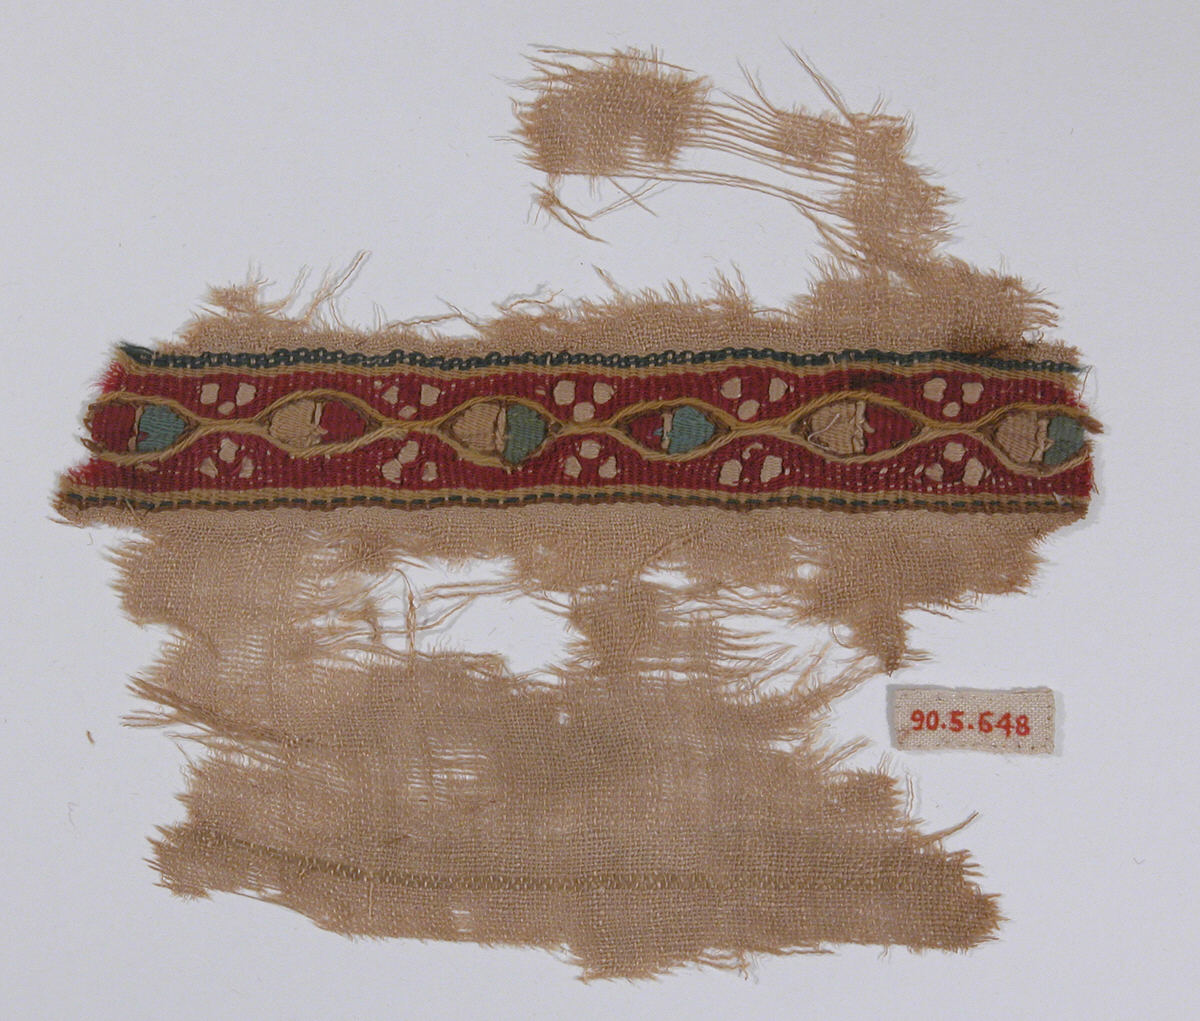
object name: textile fragment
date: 401-600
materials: linen, wool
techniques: weave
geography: egypt